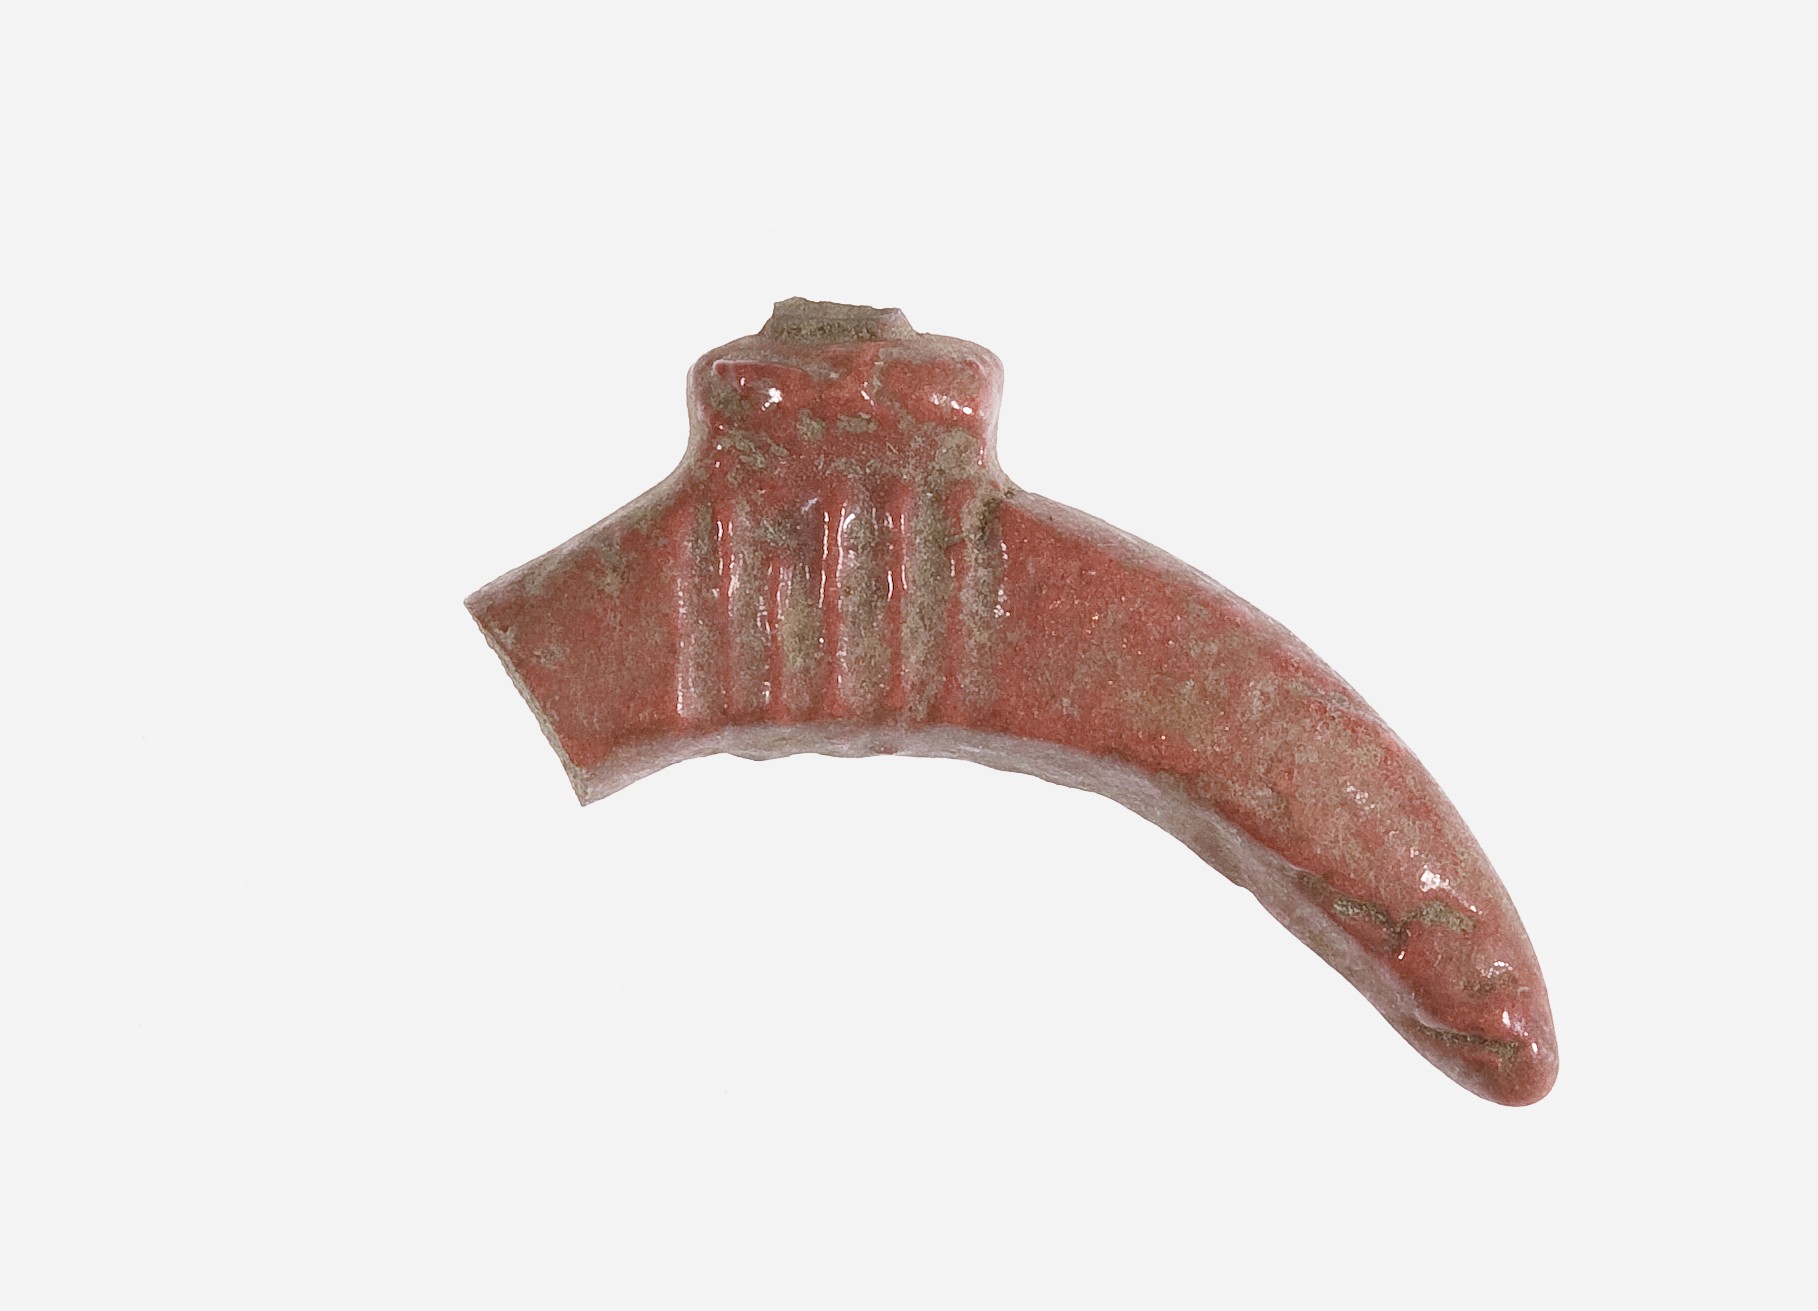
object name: amulet, crescent moon, iah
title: Crescent Moon Amulet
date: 1390-1352 BCE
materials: faience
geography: egypt